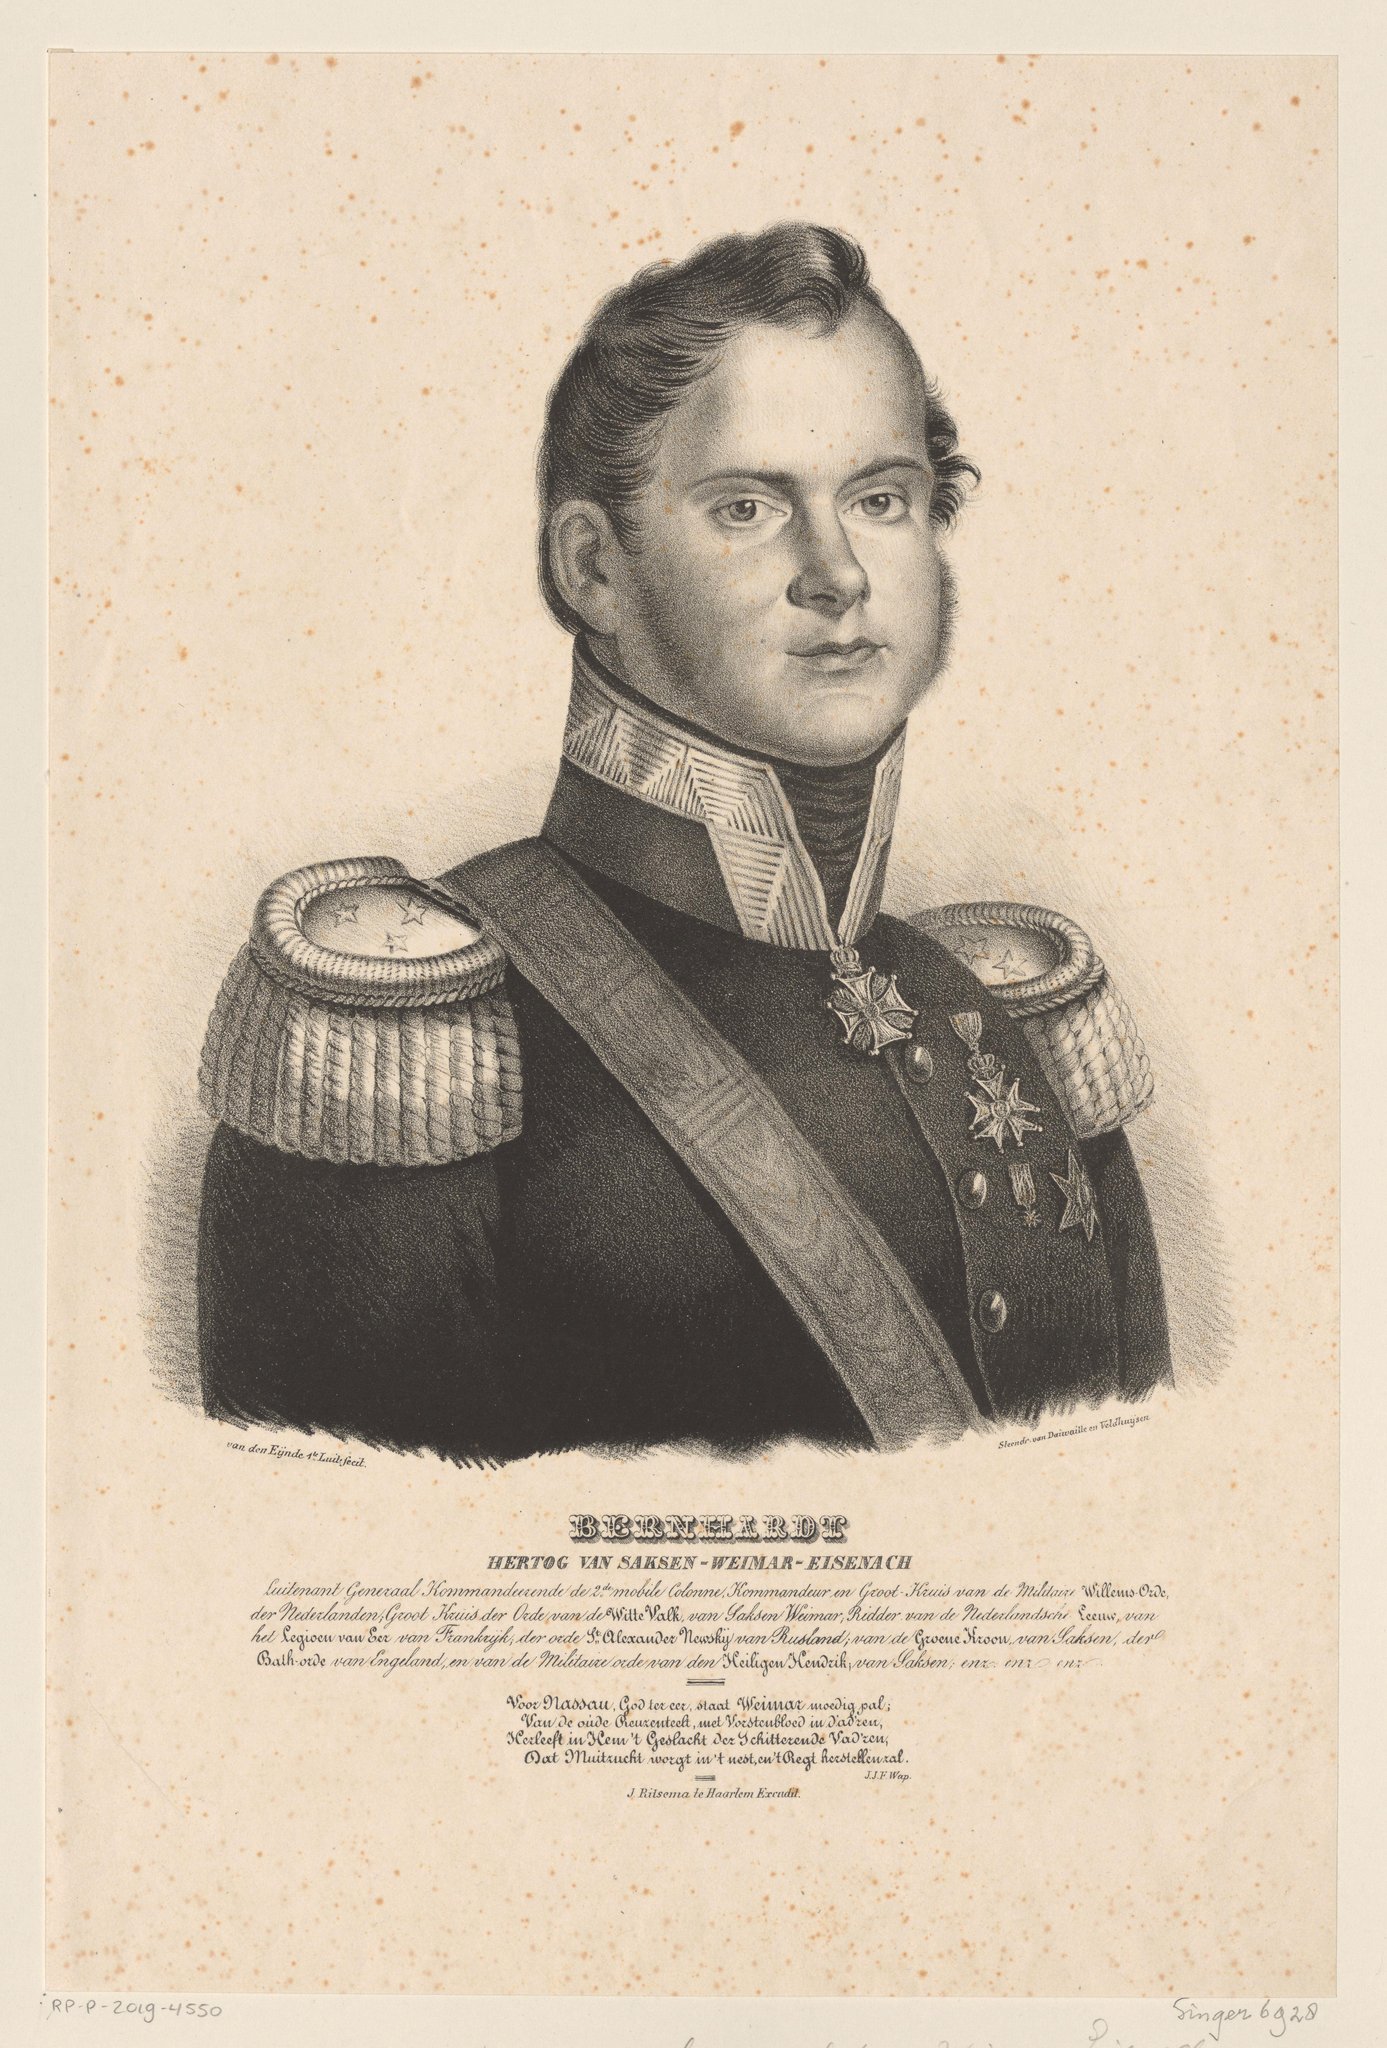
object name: print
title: Portret van Karel Bernhard, hertog van Saksen-Weimar-Eisenach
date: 1831-1832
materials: paper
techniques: lithograph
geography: haarlem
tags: karel bernhard (hertog van saksen-weimar-eisenach), historical persons, medals and other marks of military honour